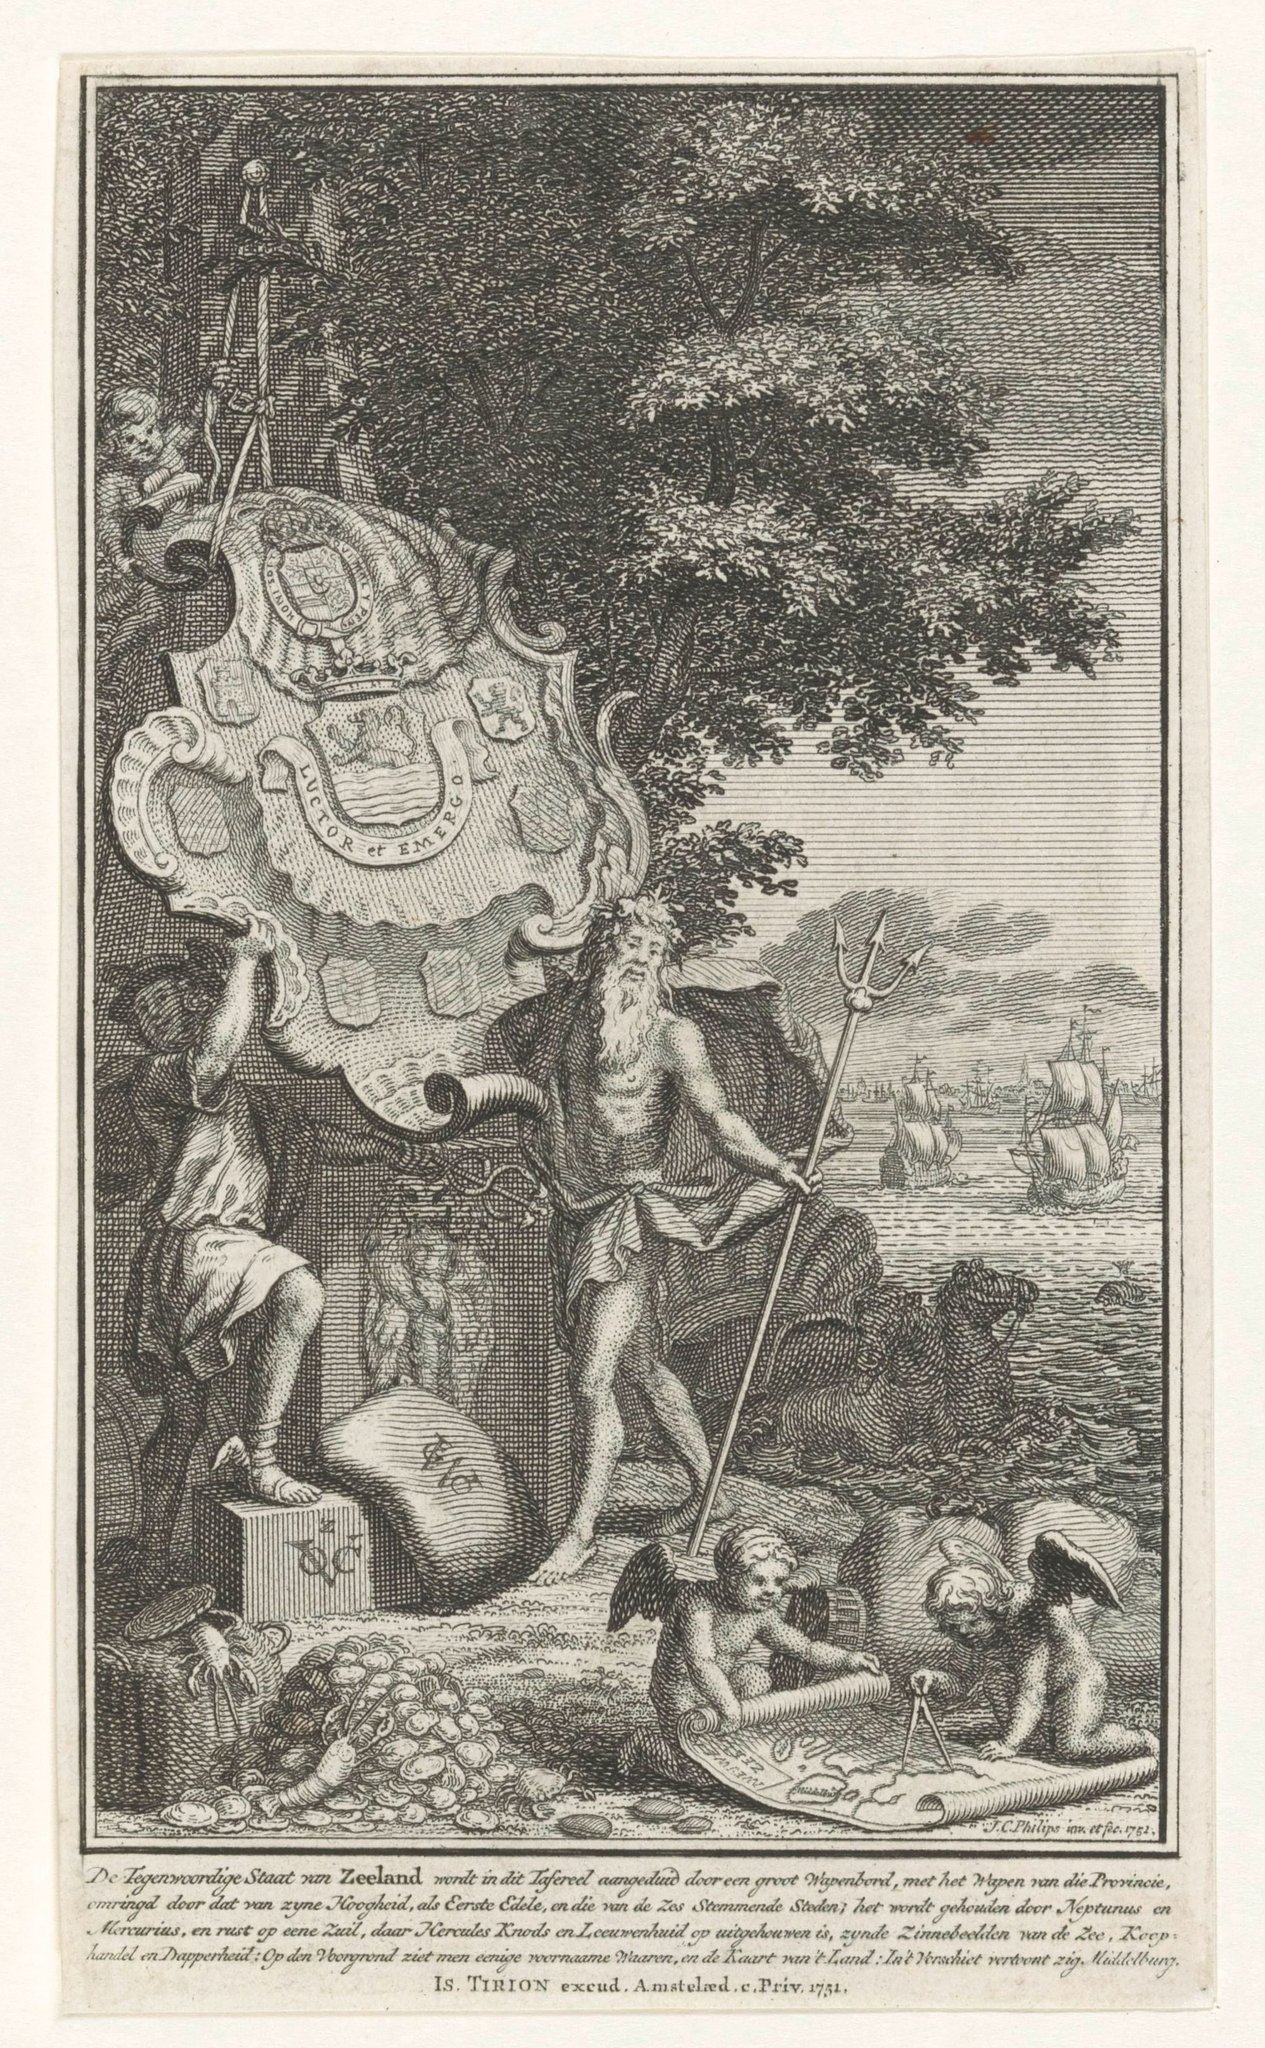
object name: titelblad, titelpagina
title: Titelpagina voor: Thomas Salmon en Jan Wagenaar, Tegenwoordige staat der Vereenigde Nederlanden, Negende deel, 1751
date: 1751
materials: paper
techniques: engraving, etching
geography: amsterdam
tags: (story of) neptune (poseidon), coat of arms (as symbol of the state, etc.), (story of) mercury (hermes), maps, atlases, zeeland, middelburg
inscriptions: collector's mark: Lugt 2228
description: Titelpagina voor: Salmon, Thomas en Wagenaar, Jan. Tegenwoordige staat der Vereenigde Nederlanden, Negende deel. Amsterdam: Tirion, Isaak, 1751. / Titelpagina voor: Salmon, Thomas. Hedendaagsche historie of tegenwoordige staat van alle volkeren, XIXde deel. Amsterdam: Tirion, Isaak, 1751. Tussen 1739 en 1804 verscheen bij de Amsterdamse uitgever Isaak Tirion een serie van 23 delen ‘Tegenwoordige staat der Vereenigde Nederlanden’, een verzamelwerk voor een groot deel van de hand van Jan Wagenaar. Deze 23 delen waren een onderdeel van een veel groter werk, de ‘Hedendaagsche historie of tegenwoordige staat van alle volkeren’, waarvan het eerste deel in 1729 was verschenen. Beide series hebben een eigen nummering: de delen 1 t/m 23 van de serie over de Vereenigde Nederlanden zijn genummerd 11 t/m 33 van de Tegenwoordige staat van alle volkeren. Prent afkomstig uit een plakalbum met titelprenten, ornamenten etc. op blauw papier in 1983 uit elkaar gehaald. Volgens een notitie op verso zat de prent op p. 195 van dit album.